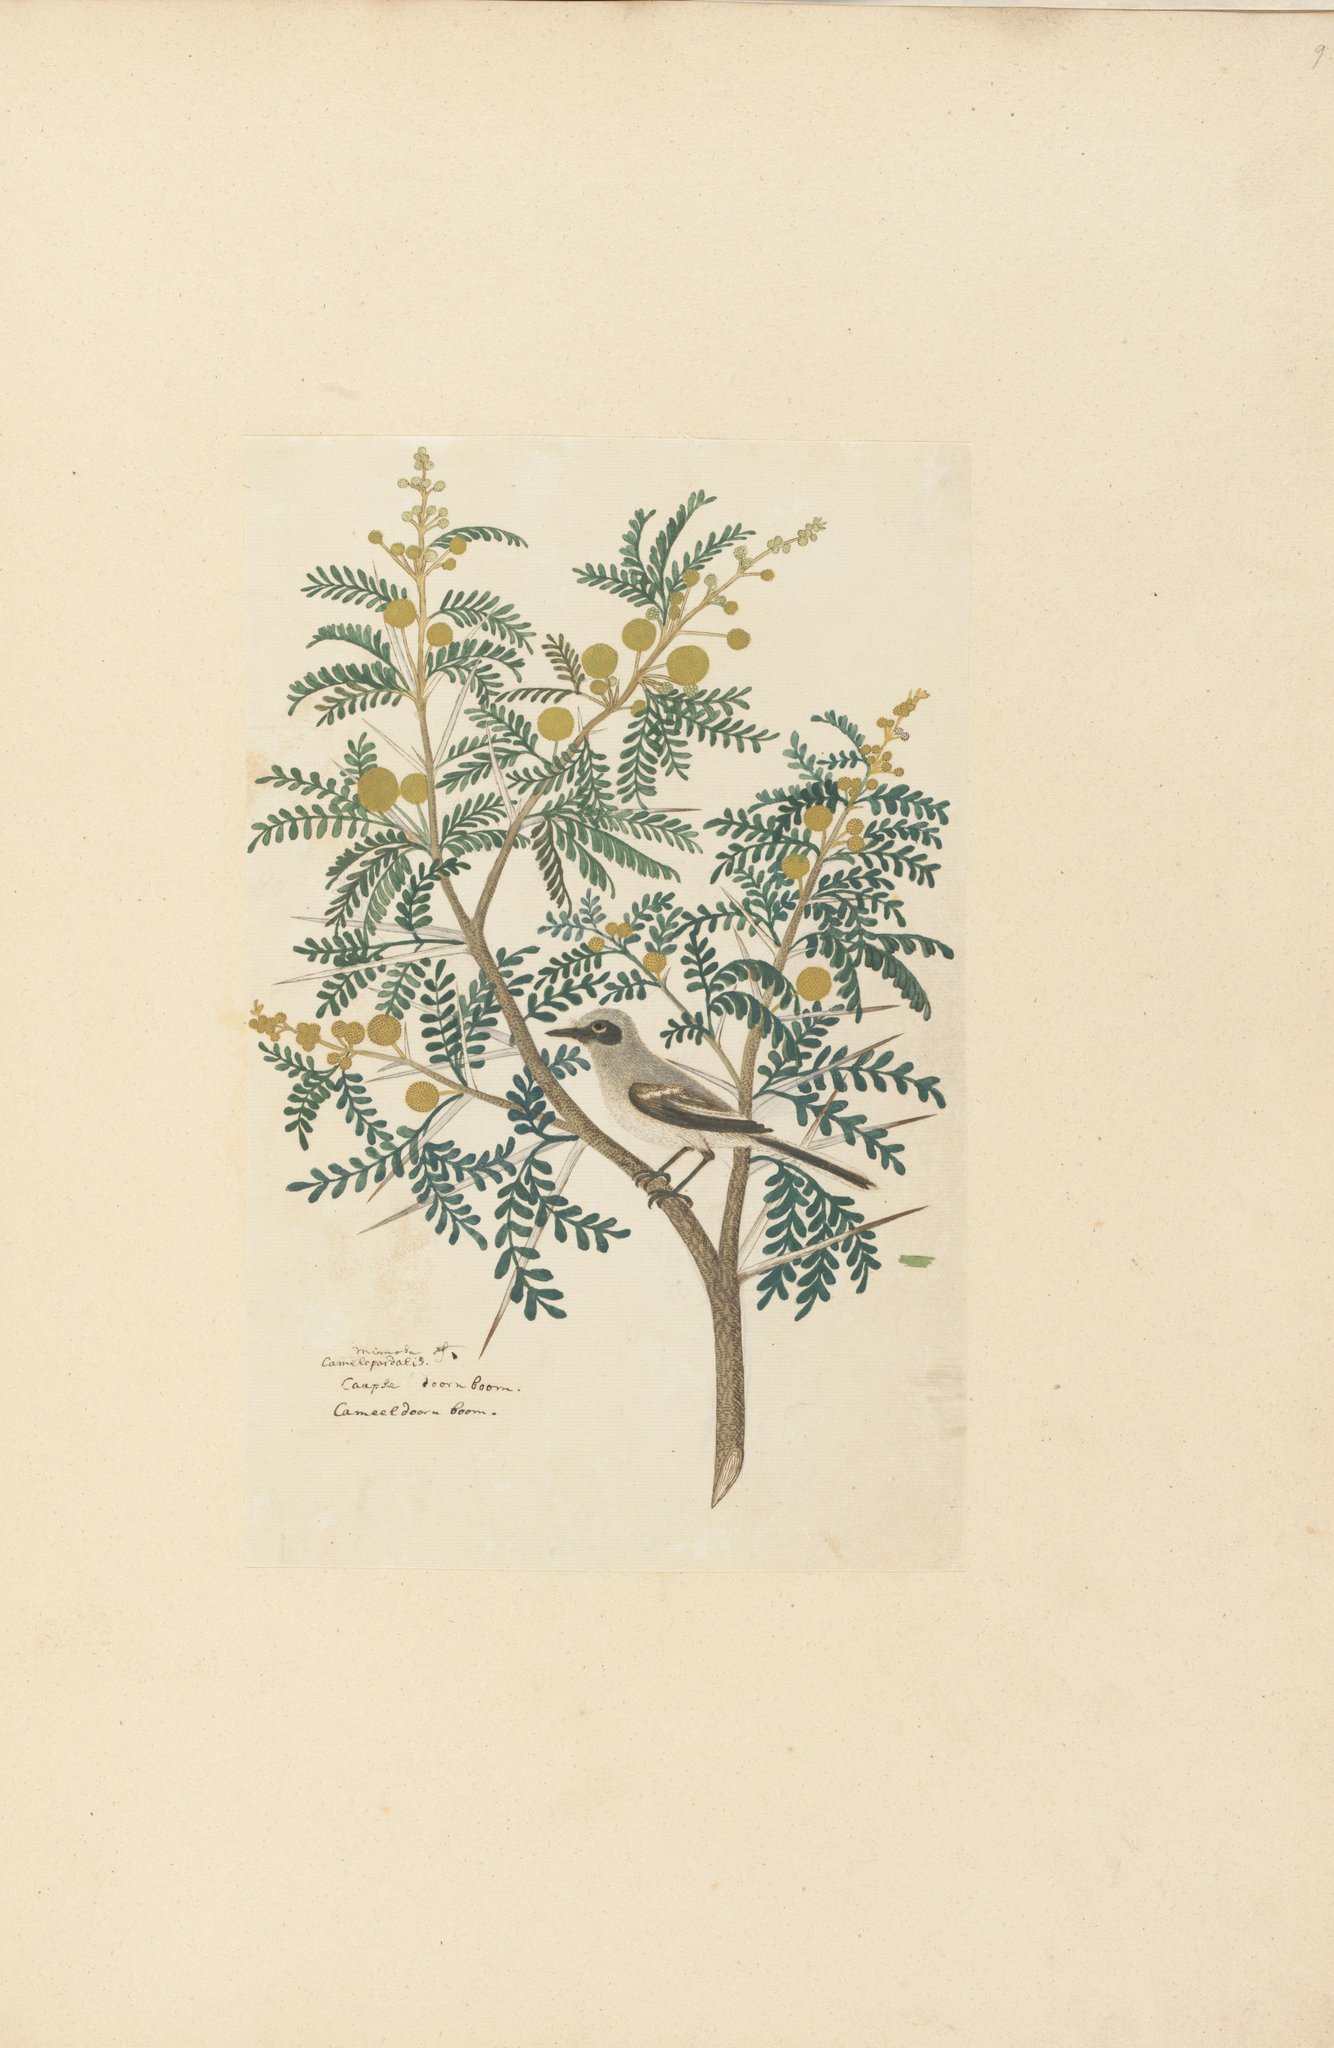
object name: album leaf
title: Acacia karroo Hayne or Vachellia karroo (Karoo thorn, with an unidentified birt ?wagtail)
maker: robert jacob gordon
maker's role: draughtsman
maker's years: 1743-1795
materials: chalk, ink, paper, pencil, watercolor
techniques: brush, pen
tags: plants; vegetation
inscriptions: annotation: ‘mimosa / camelopardaeis. / Caapse doornboom. / Cameeldoorn boom.’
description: De tekening is gemaakt tijdens de eerste of de vierde van Gordon's vier expedities door de Kaapprovincie, van oktober 1777 tot maart 1786. Sommige (soort)namen kunnen zijn gewijzigd, gezien reorganisatie in plantentaxonomie gedurende de afgelopen jaren.